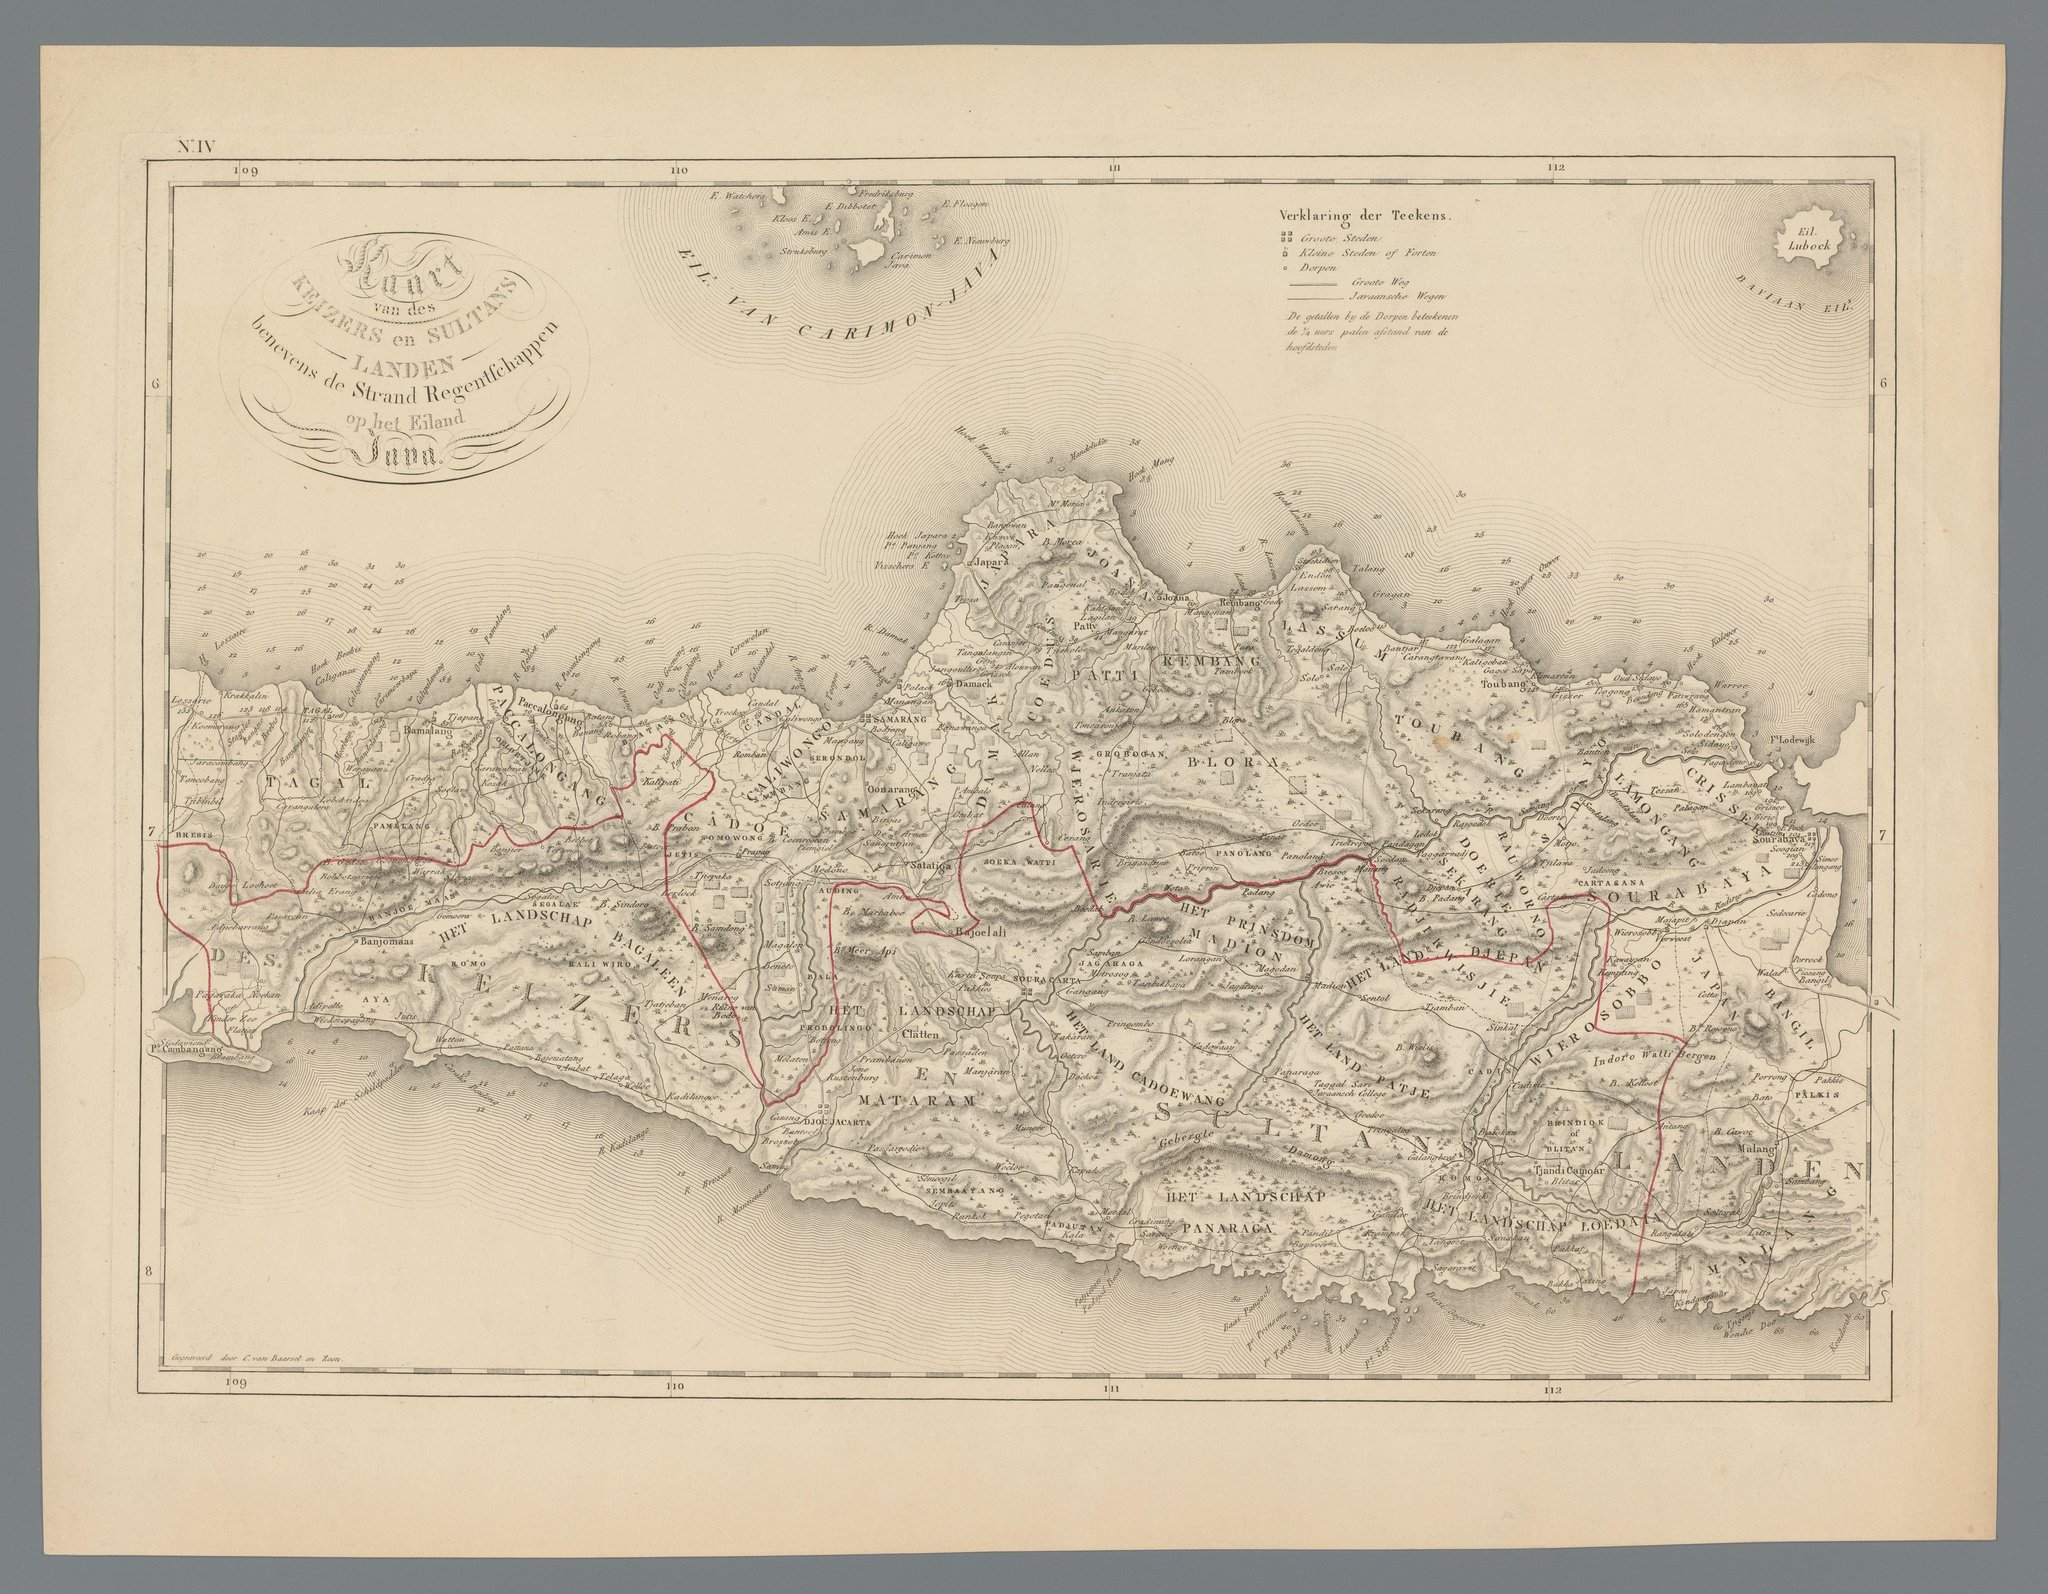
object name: print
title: Kaart van Java waarop de verdeling van het land onder de Javaanse vorsten is aangegeven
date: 1817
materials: paper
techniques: engraving, etching, hand coloring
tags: maps of separate countries or regions, java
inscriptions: collector's mark: Lugt 2228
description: Prent gebruikt in: Bosch, Johannes van den. Atlas der overzeesche bezittingen van Zijne Majesteit den Koning der Nederlanden. Den Haag en Amsterdam: Gebroeders van Cleef, 1817.